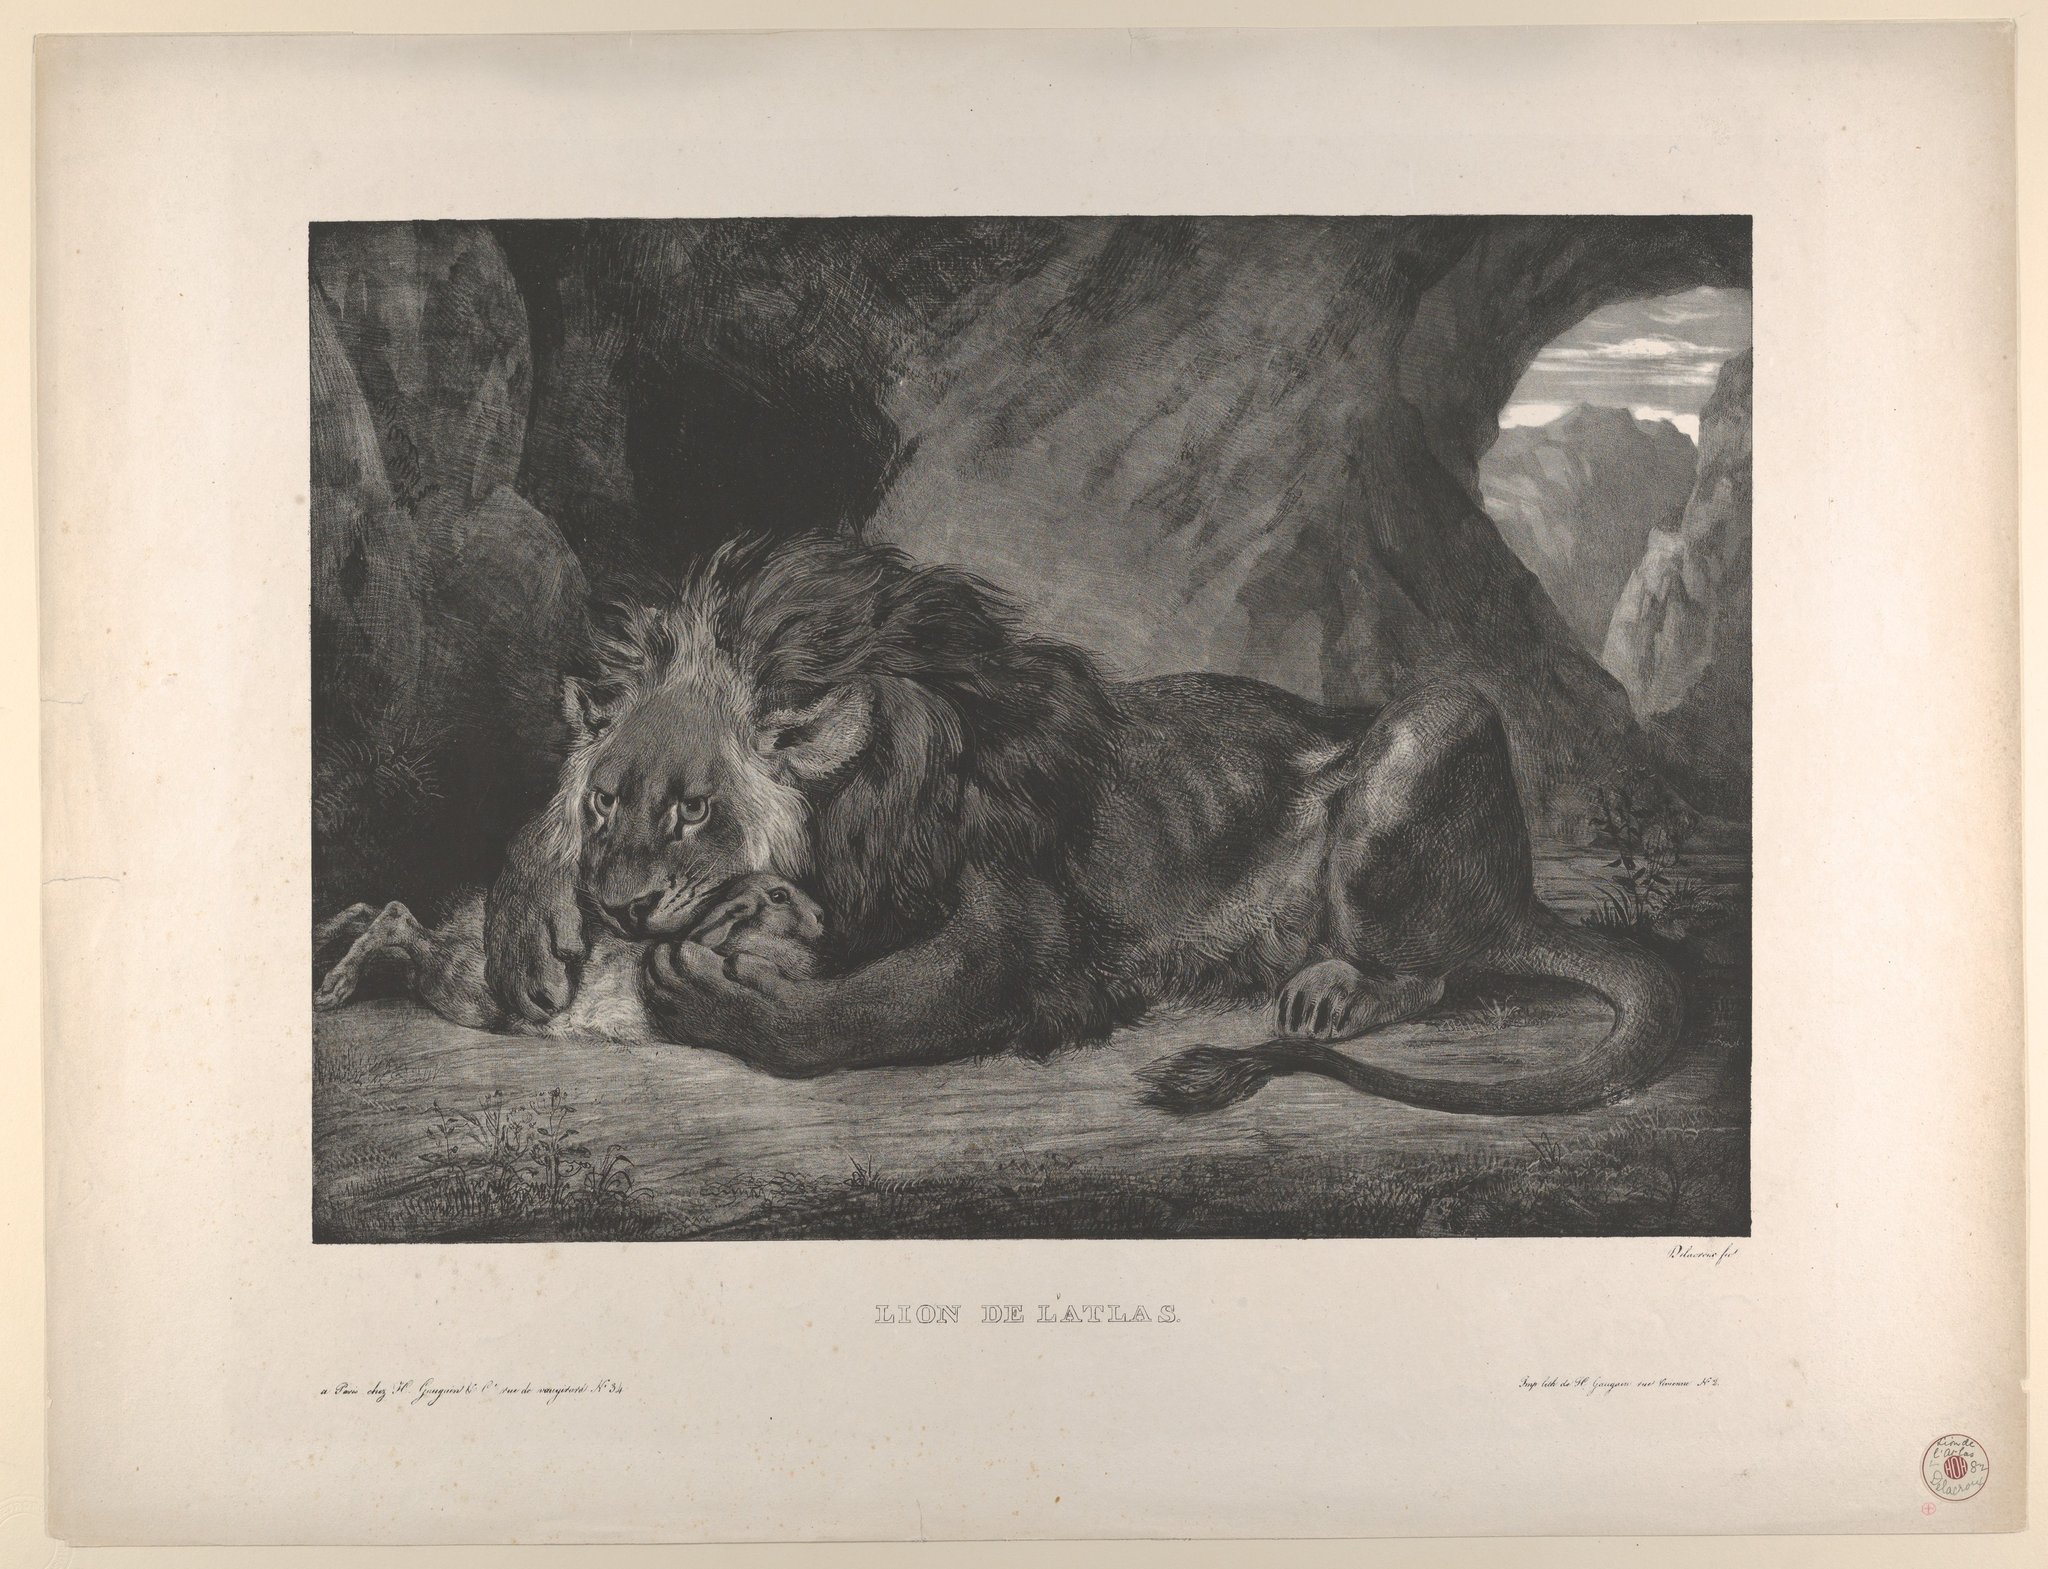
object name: print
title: Lion of the Atlas Mountains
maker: eugène delacroix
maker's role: artist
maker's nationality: french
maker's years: 1798-1863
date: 1829-1830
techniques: lithograph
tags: hunting,lions,rabbits